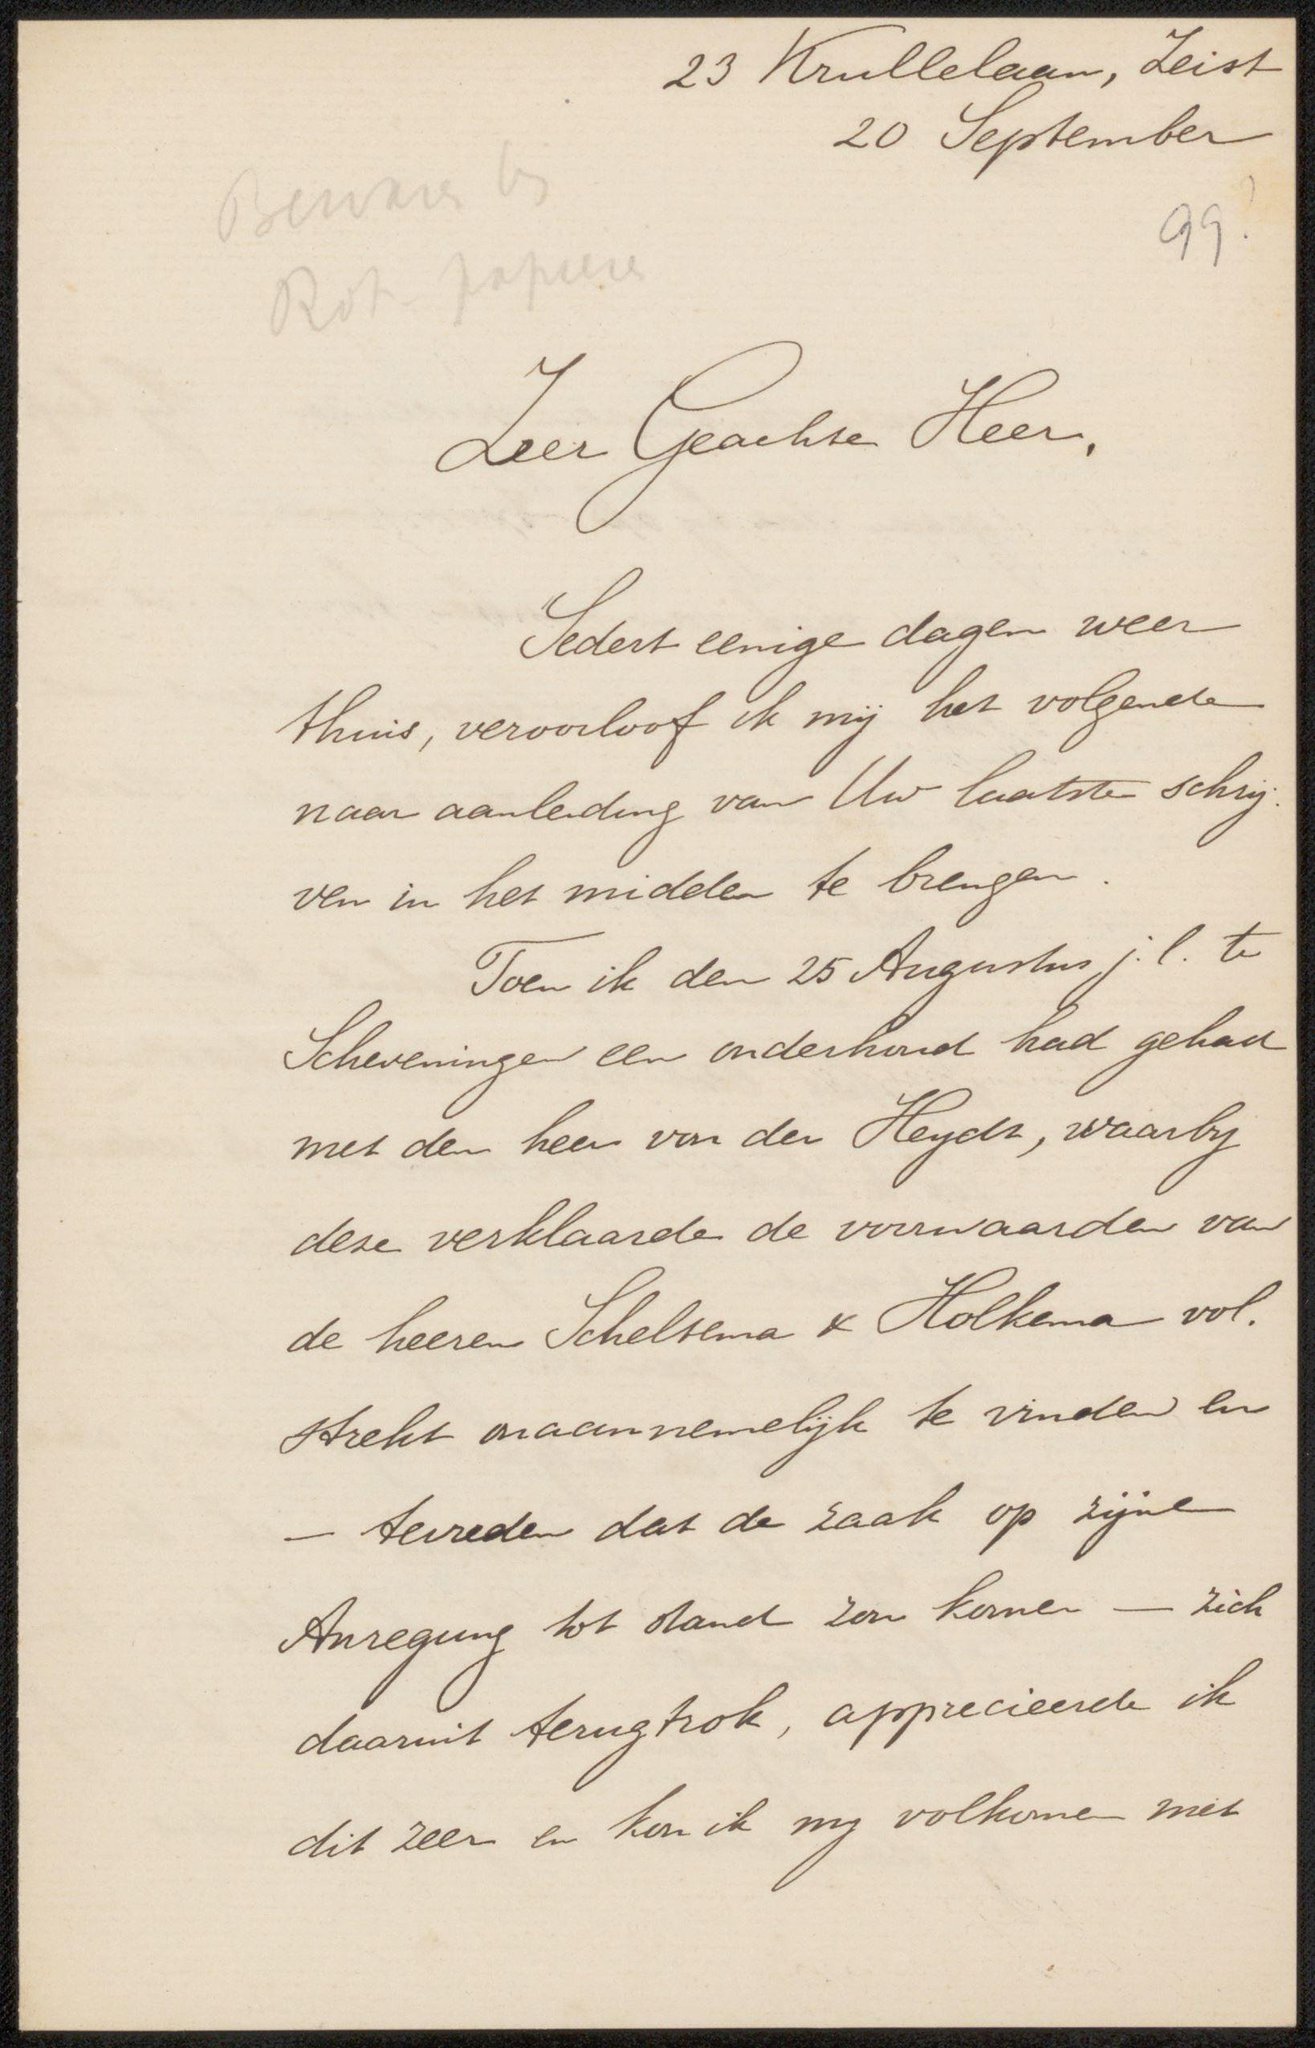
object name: letter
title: Brief aan Jan Veth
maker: cornelis hofstede de groot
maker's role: kunsthistoricus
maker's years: 1863-1940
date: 1874-1925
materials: ink, paper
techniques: pen, writing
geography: zeist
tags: dordrecht, designer, jan veth, leiden, amsterdam, painter, print maker, draughtsman, rembrandt van rijn, printed matter, berlin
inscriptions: collector's mark: ‘RPK’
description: Brief gedateerd 20 September door schrijver, met toevoeging 99? in latere hand.